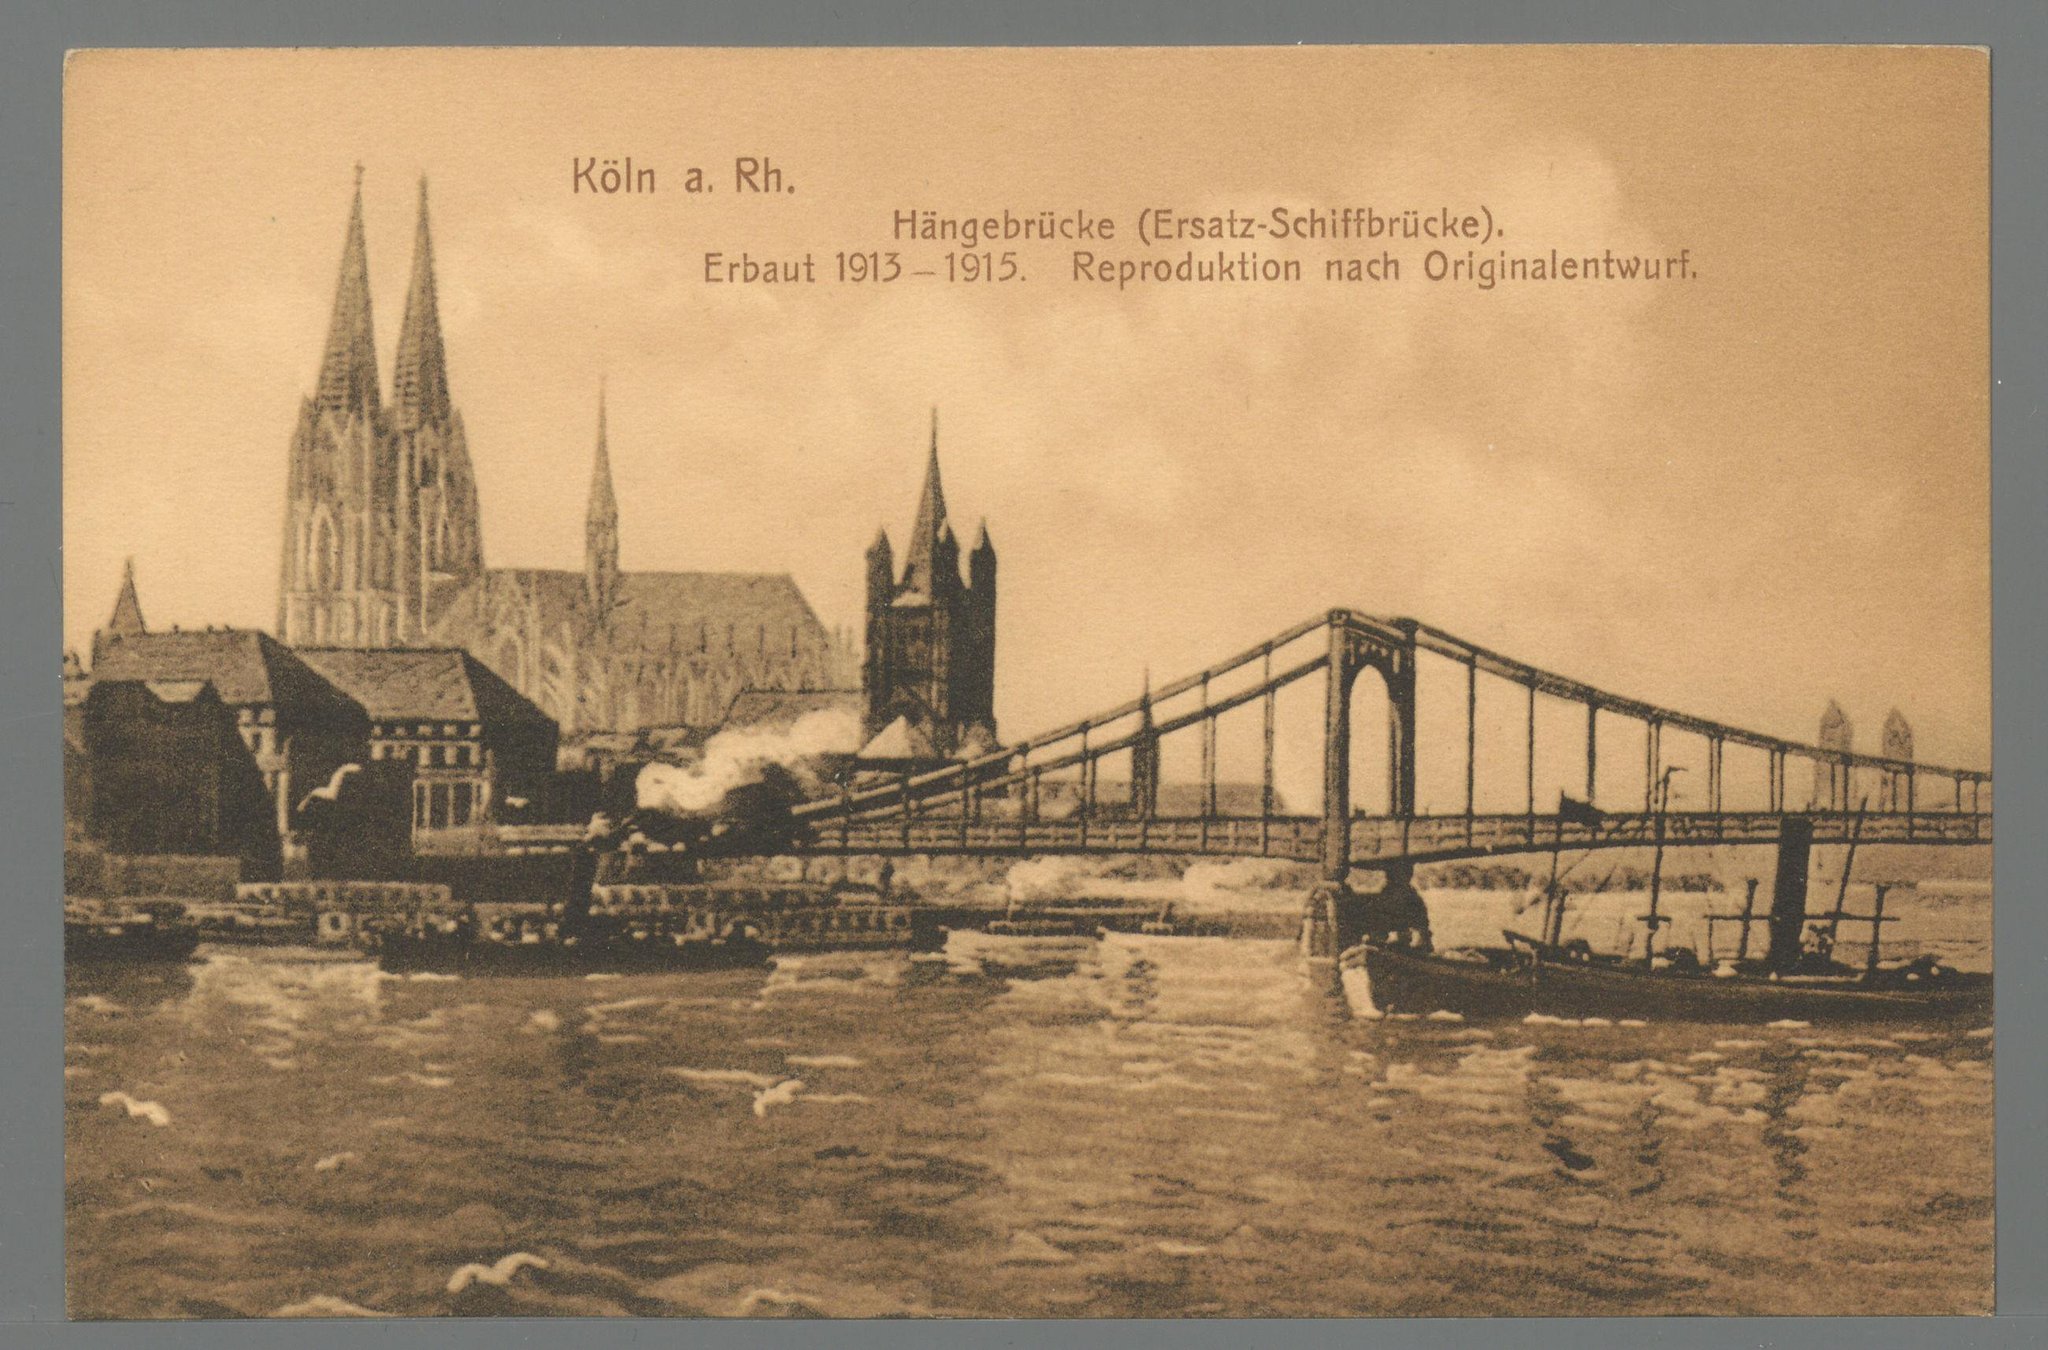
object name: ansichtkaart, prentbriefkaart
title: Köln a. Rh. Hängebrücke (Ersatz-Schiffbrücke). Erbaut 1913-1915. Reproduktion nach Originalentwurf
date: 1915-1920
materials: cardboard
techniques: photograph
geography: cologne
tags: church (exterior), canals, waters (in city), bridge in city across river, canal, etc., cologne